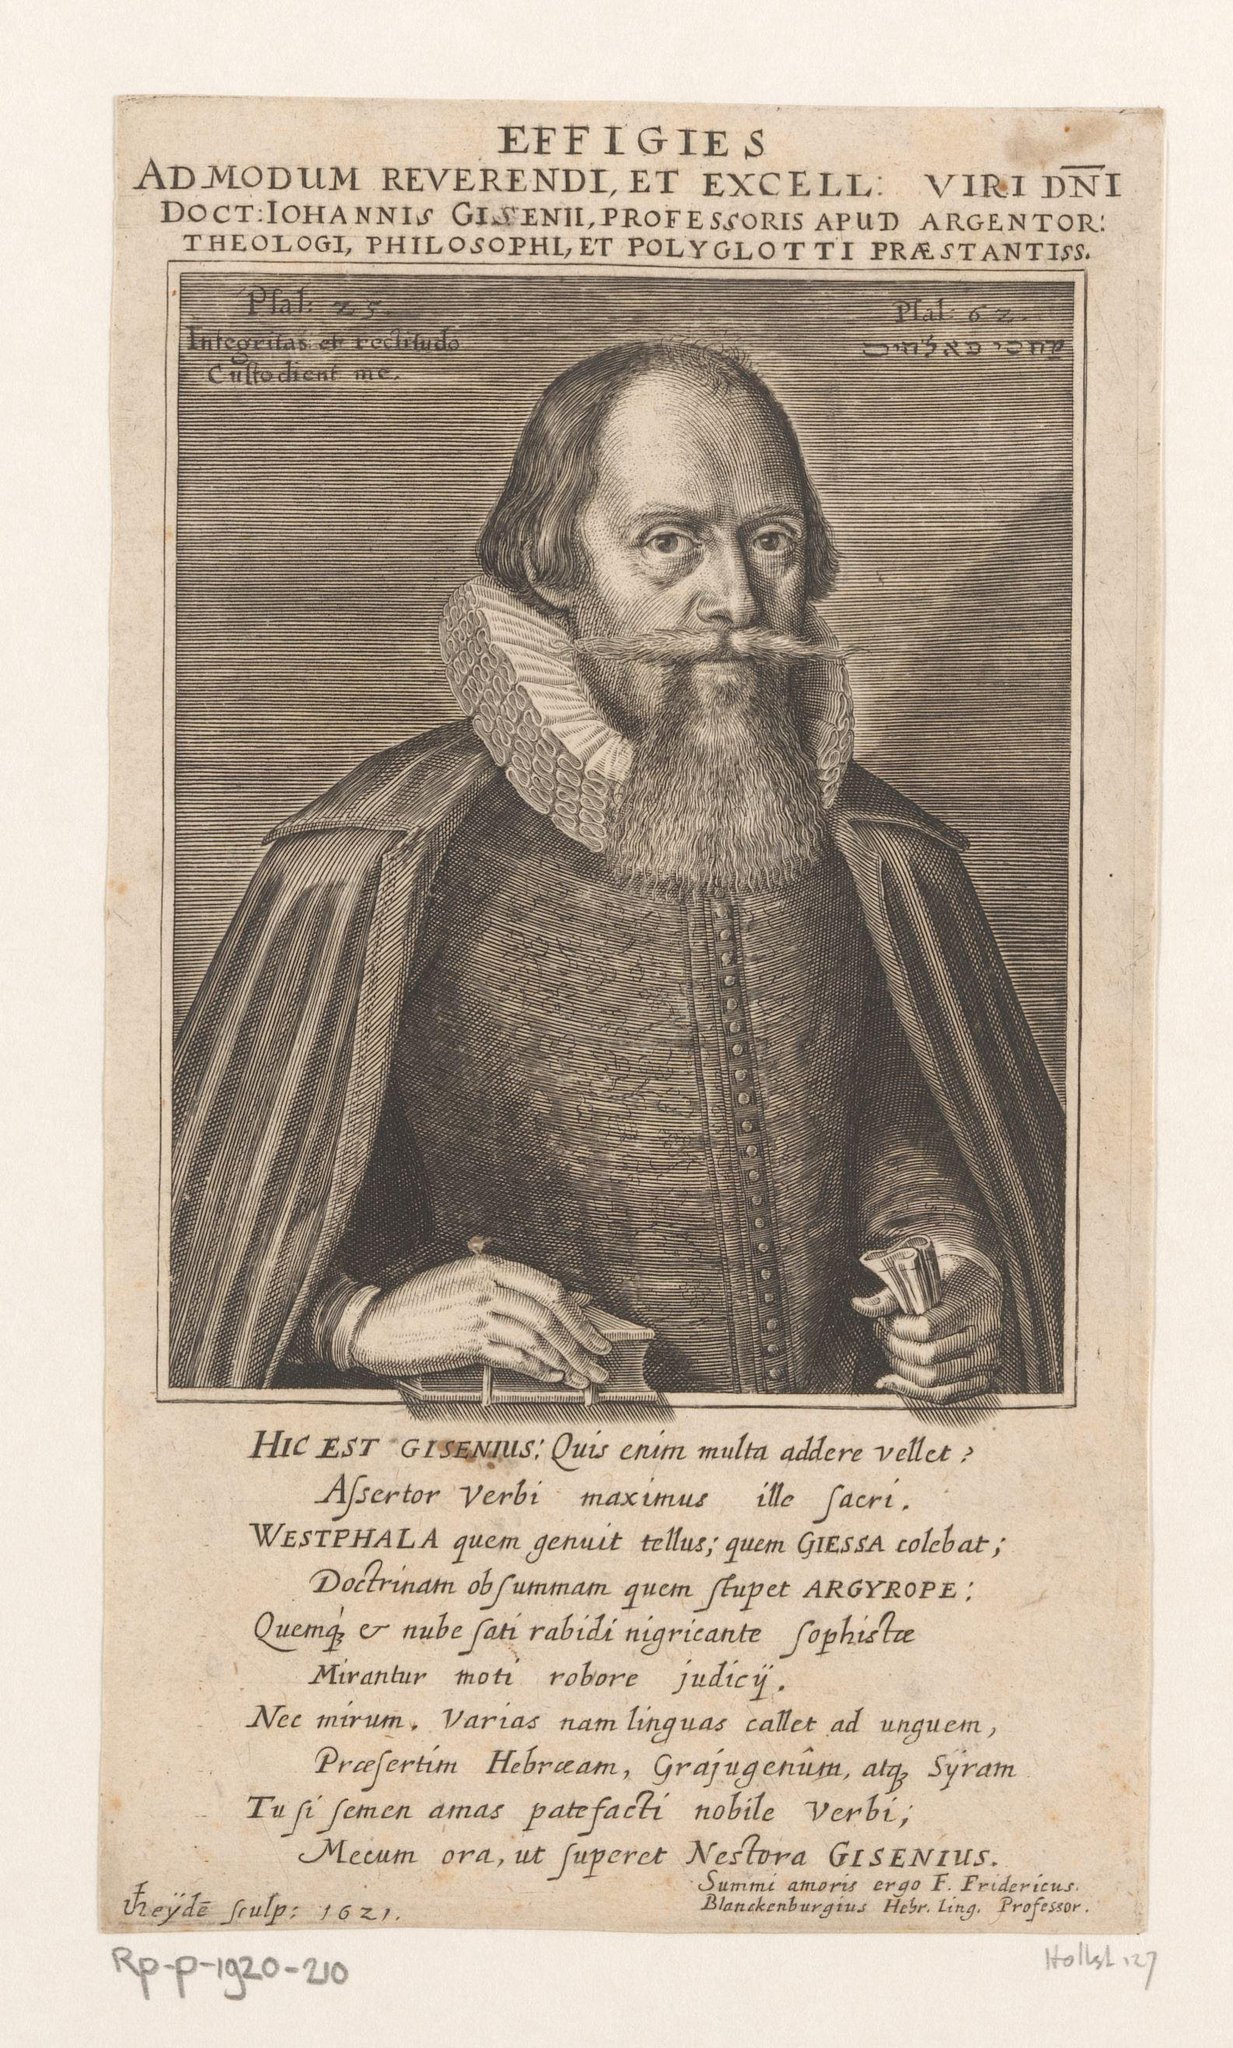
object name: print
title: Portret van Johannes Gisenius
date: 1621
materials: paper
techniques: engraving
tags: theologian, gloves, mittens, etc., historical persons, book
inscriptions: collector's mark: Lugt 2228